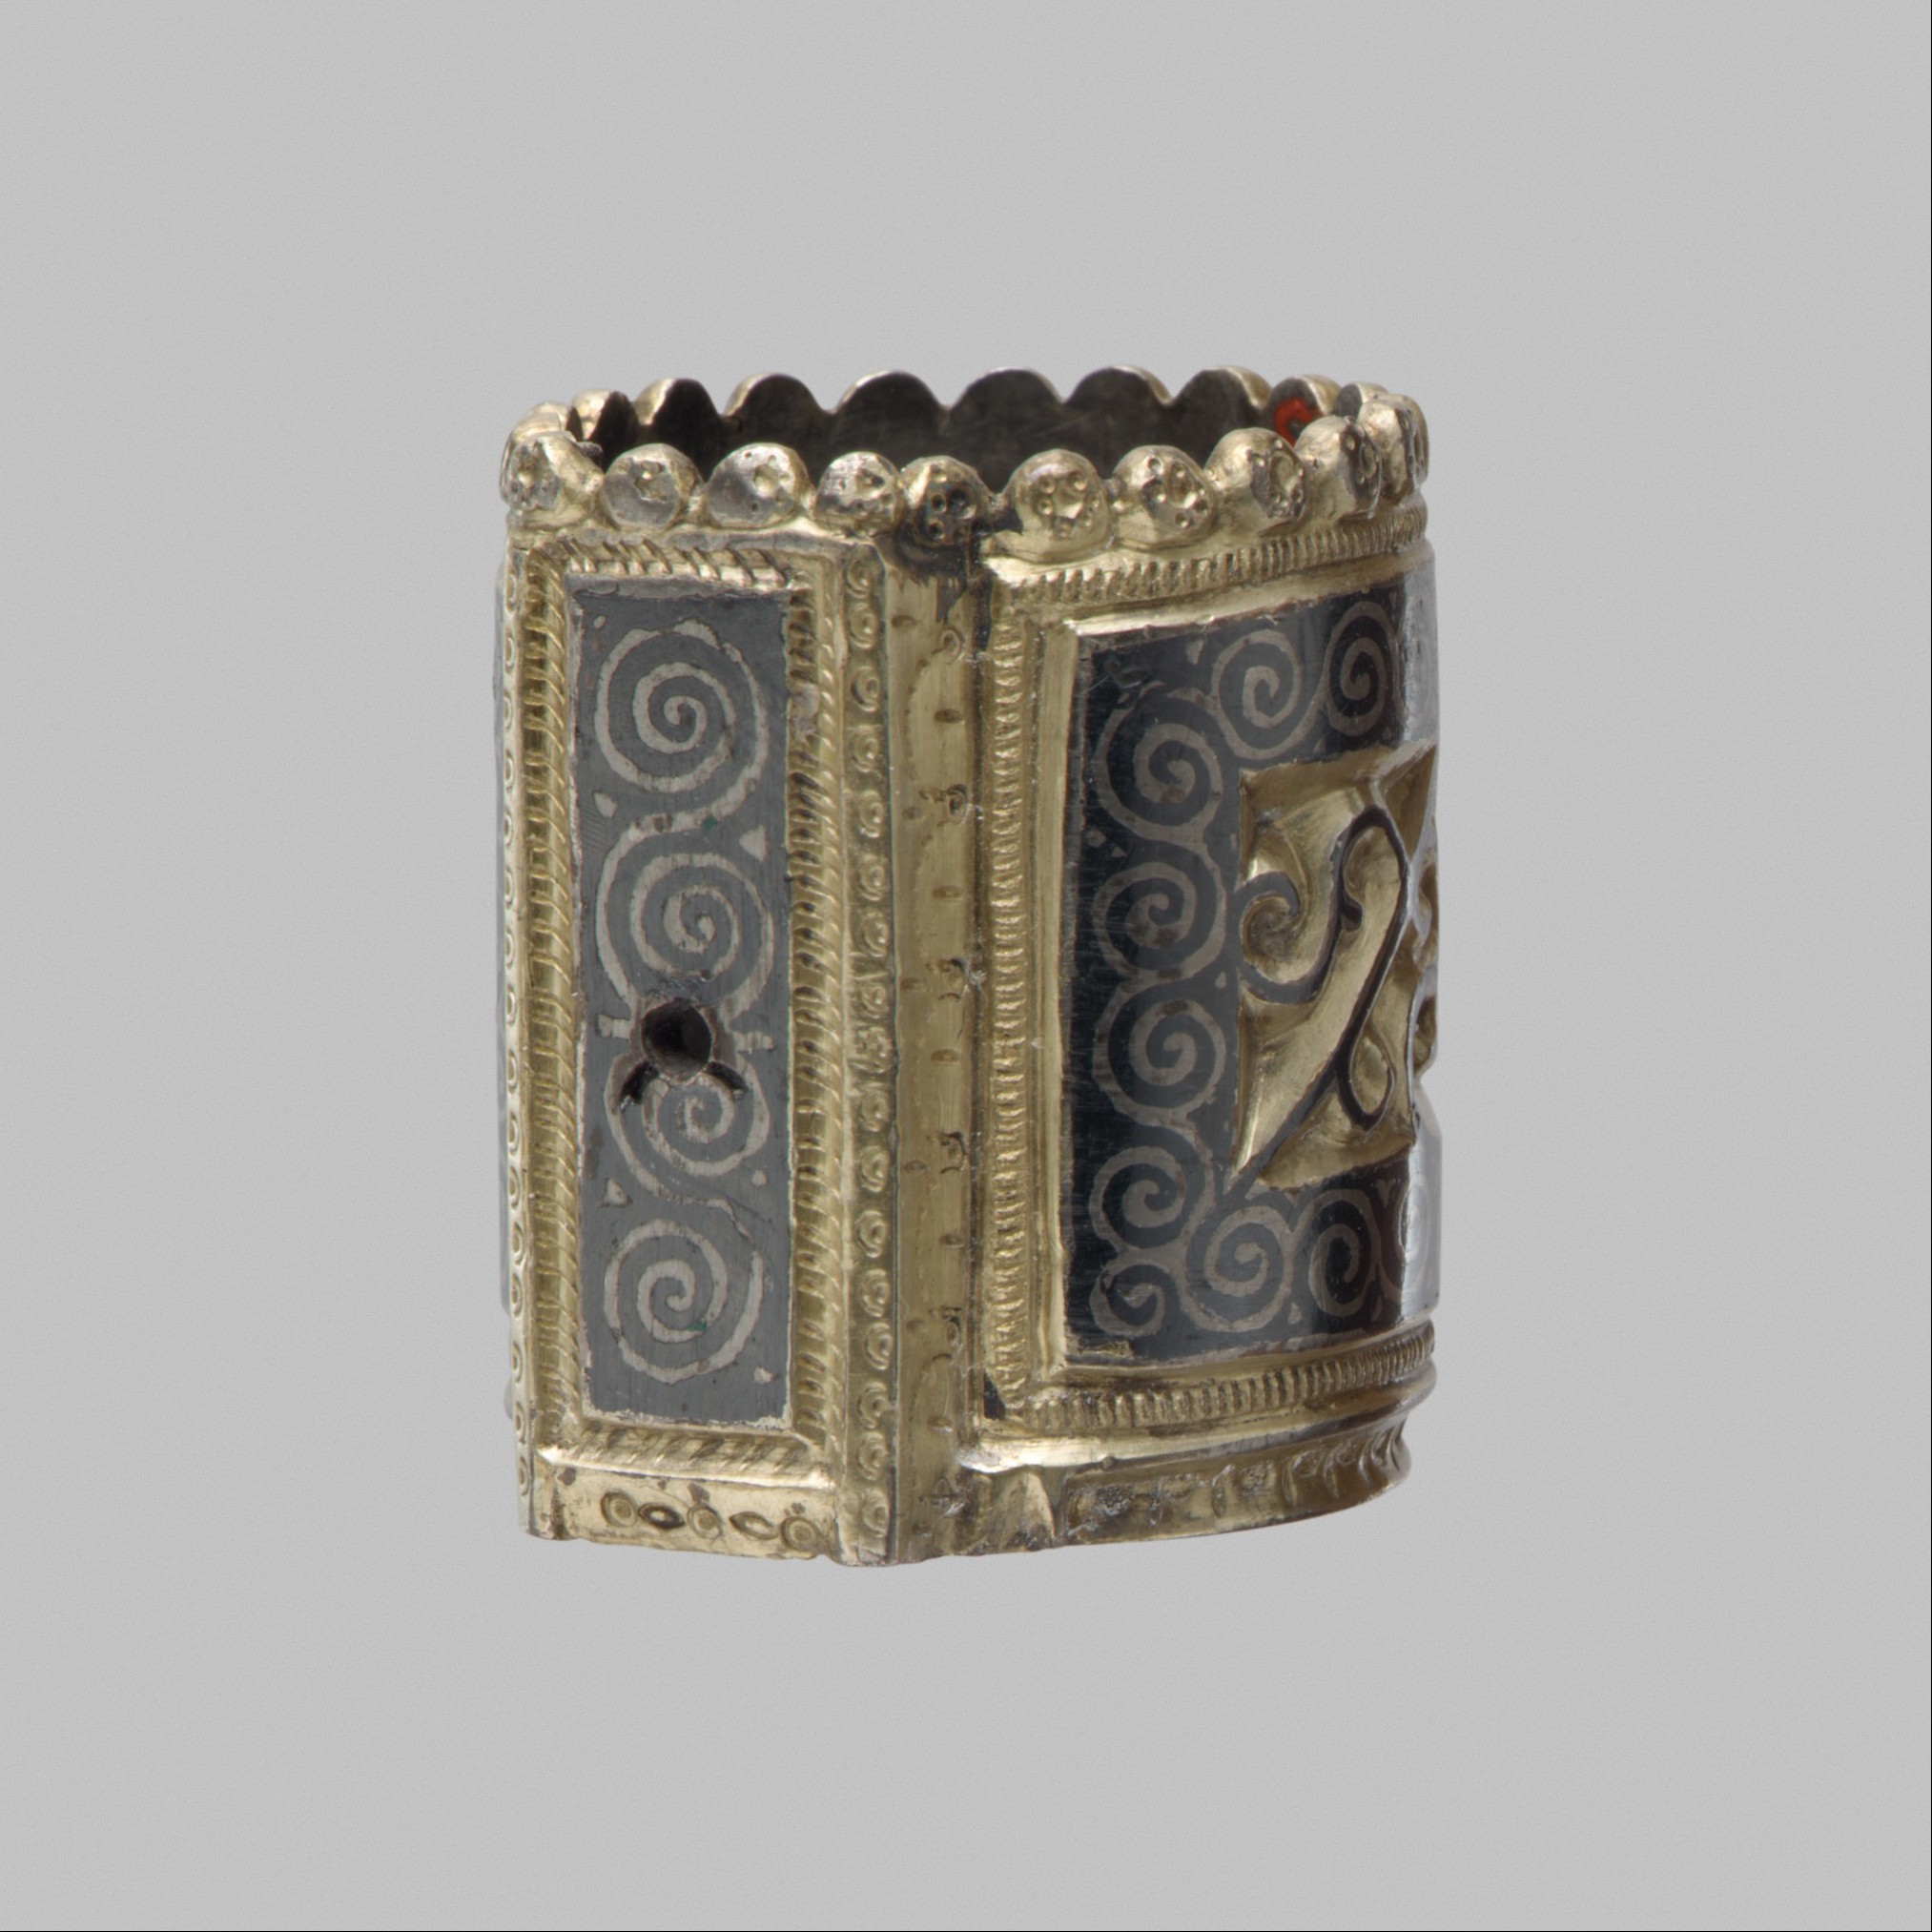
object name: mount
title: Mount for Spear Shaft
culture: roman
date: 400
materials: niello, silver gilt